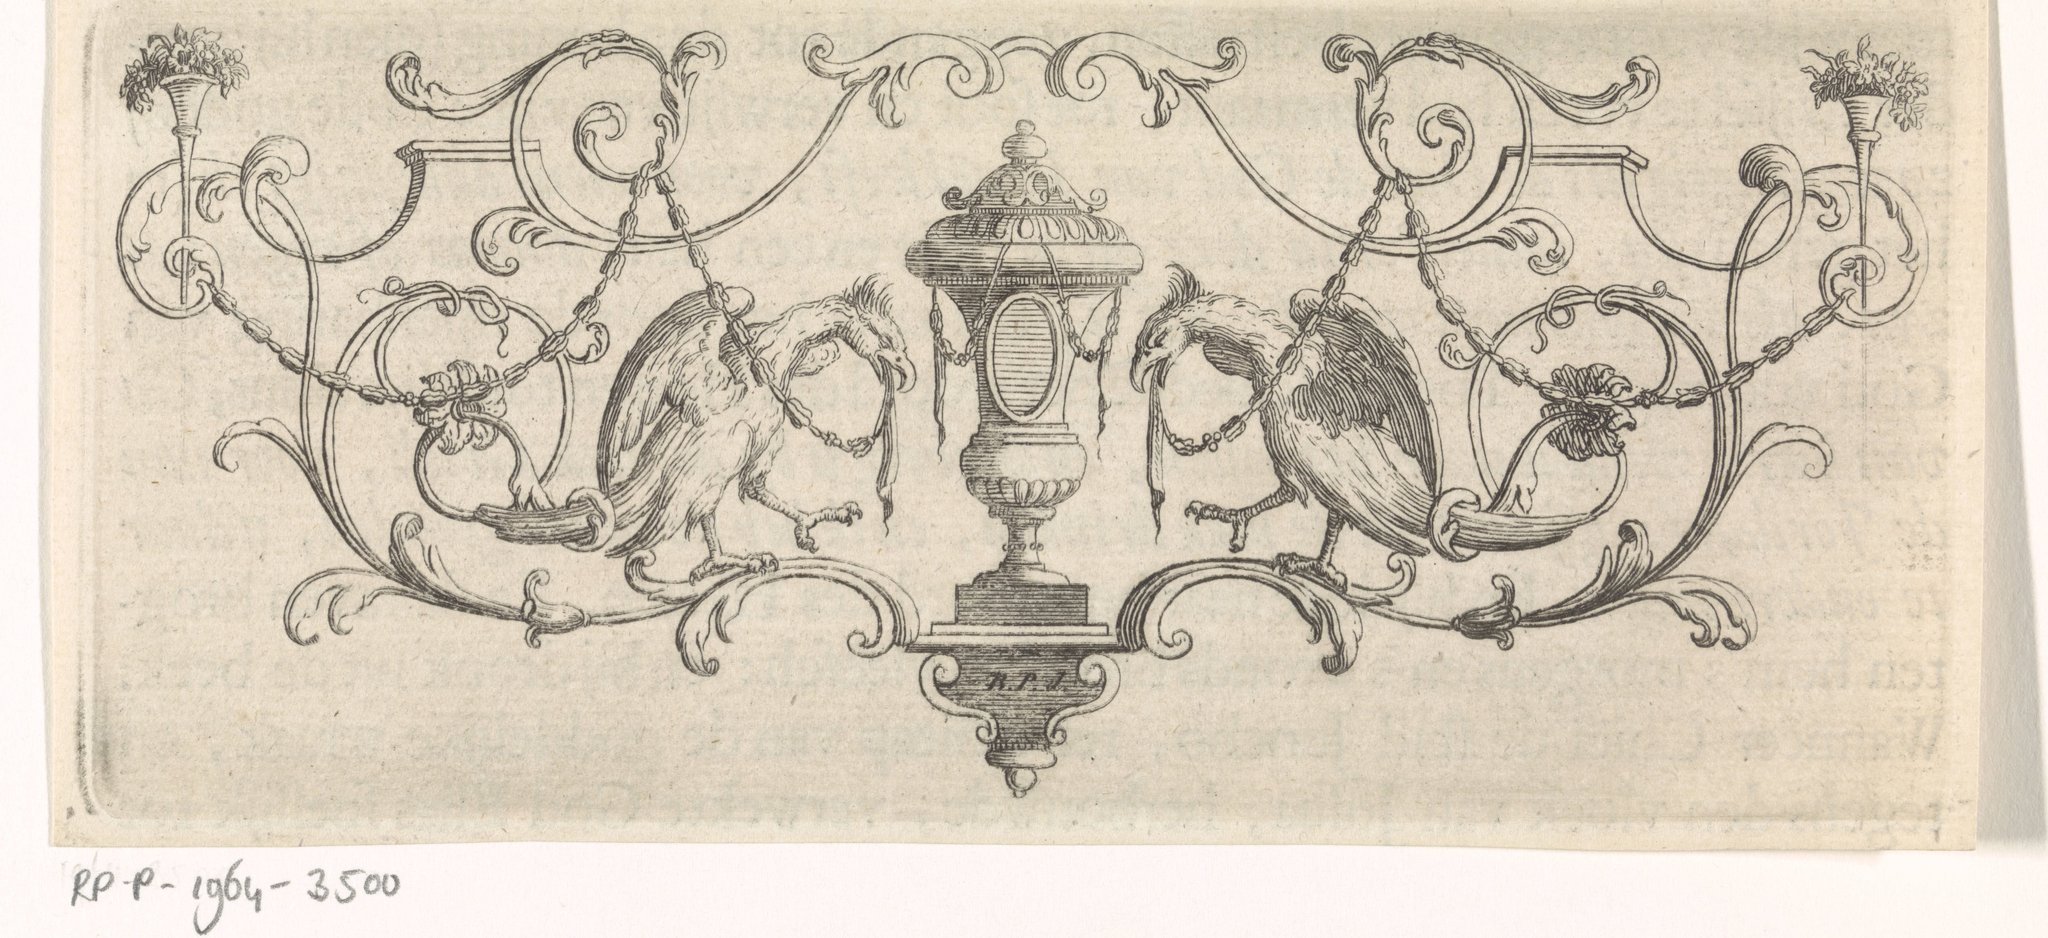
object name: ornament print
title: Vaas geflankeerd door vogels met guirlandes in hun bek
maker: bernard picart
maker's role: draughtsman, print maker, publisher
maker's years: 1673-1733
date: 1683-1733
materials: paper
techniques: etching, letterpress printing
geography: amsterdam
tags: ornament derived from animal forms, vase ~ ornament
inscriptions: collector's mark: Lugt 2228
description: Prent oorspronkelijk bedoeld voor: Figures de la Bible. Amsterdam, Bernard Picart, 1720. Prent ook gebruikt in: Taferelen der voornaamste geschiedenissen van het Oude en Nieuwe Testament (...) door de vermaarde kunstenaars Hoet, Houbraken, en Picart getekent (...) en met beschrijvingen uitgebreid. Den Haag: Pieter de Hondt, 1728. Mogelijk ook gebruikt in andere bijbels.